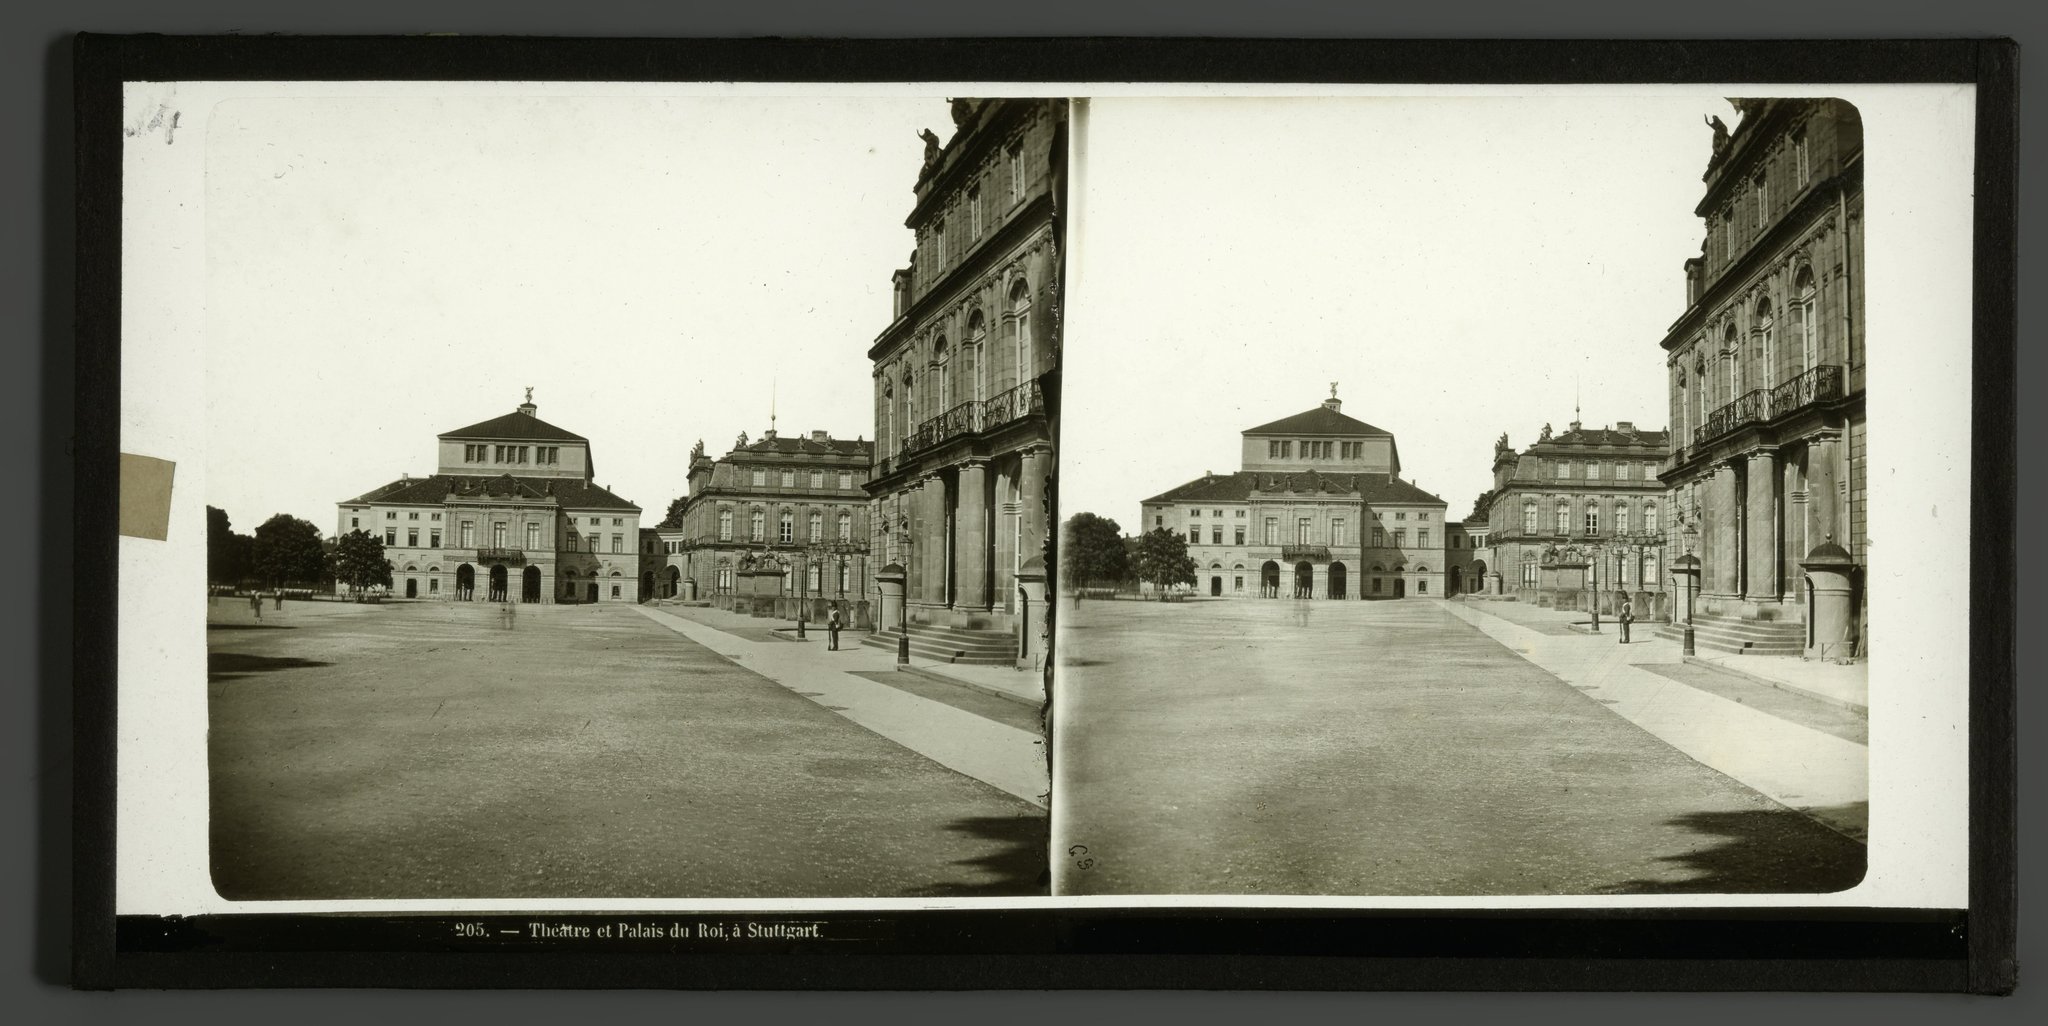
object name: stereoscopic photograph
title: Thêatre et Palais du Roi, à Stuttgart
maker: ferrier père-fils et soulier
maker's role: publisher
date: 1860-1890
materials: glass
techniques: slide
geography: stuttgart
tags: square, place, circus, etc.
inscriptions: number: ‘205.’